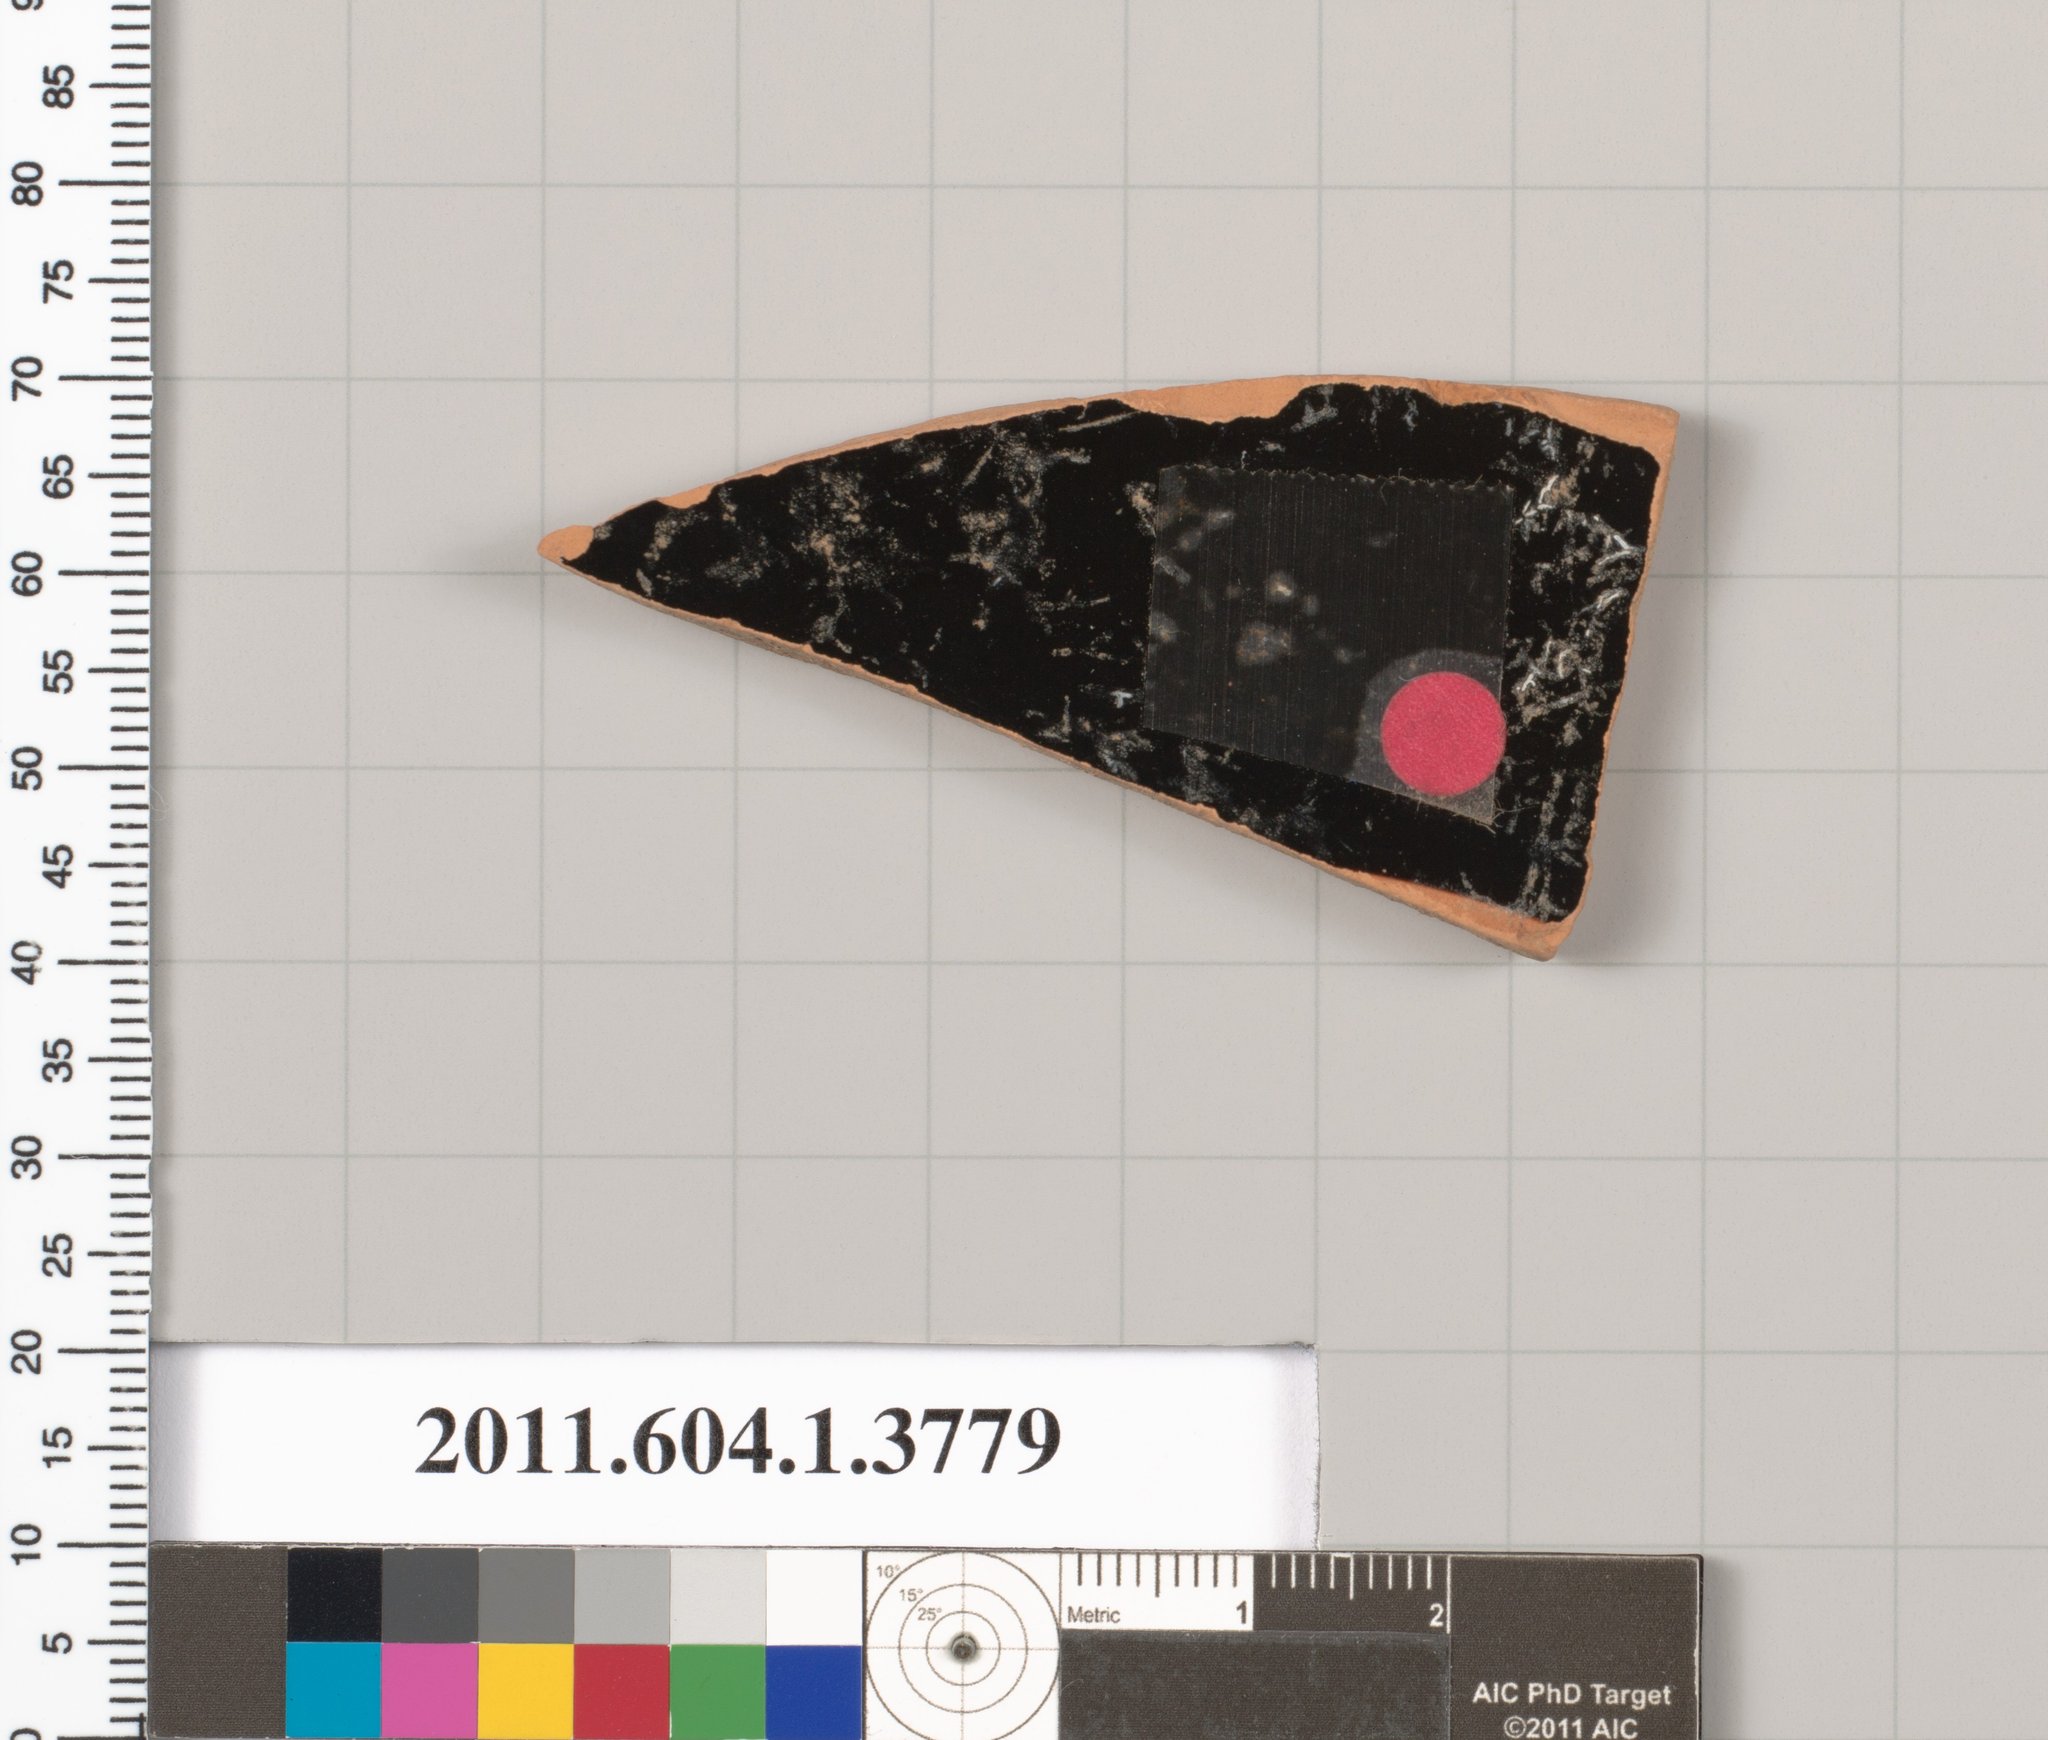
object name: kylix fragment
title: Terracotta fragment of a kylix (drinking cup)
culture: greek, attic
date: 475-451 BCE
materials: terracotta